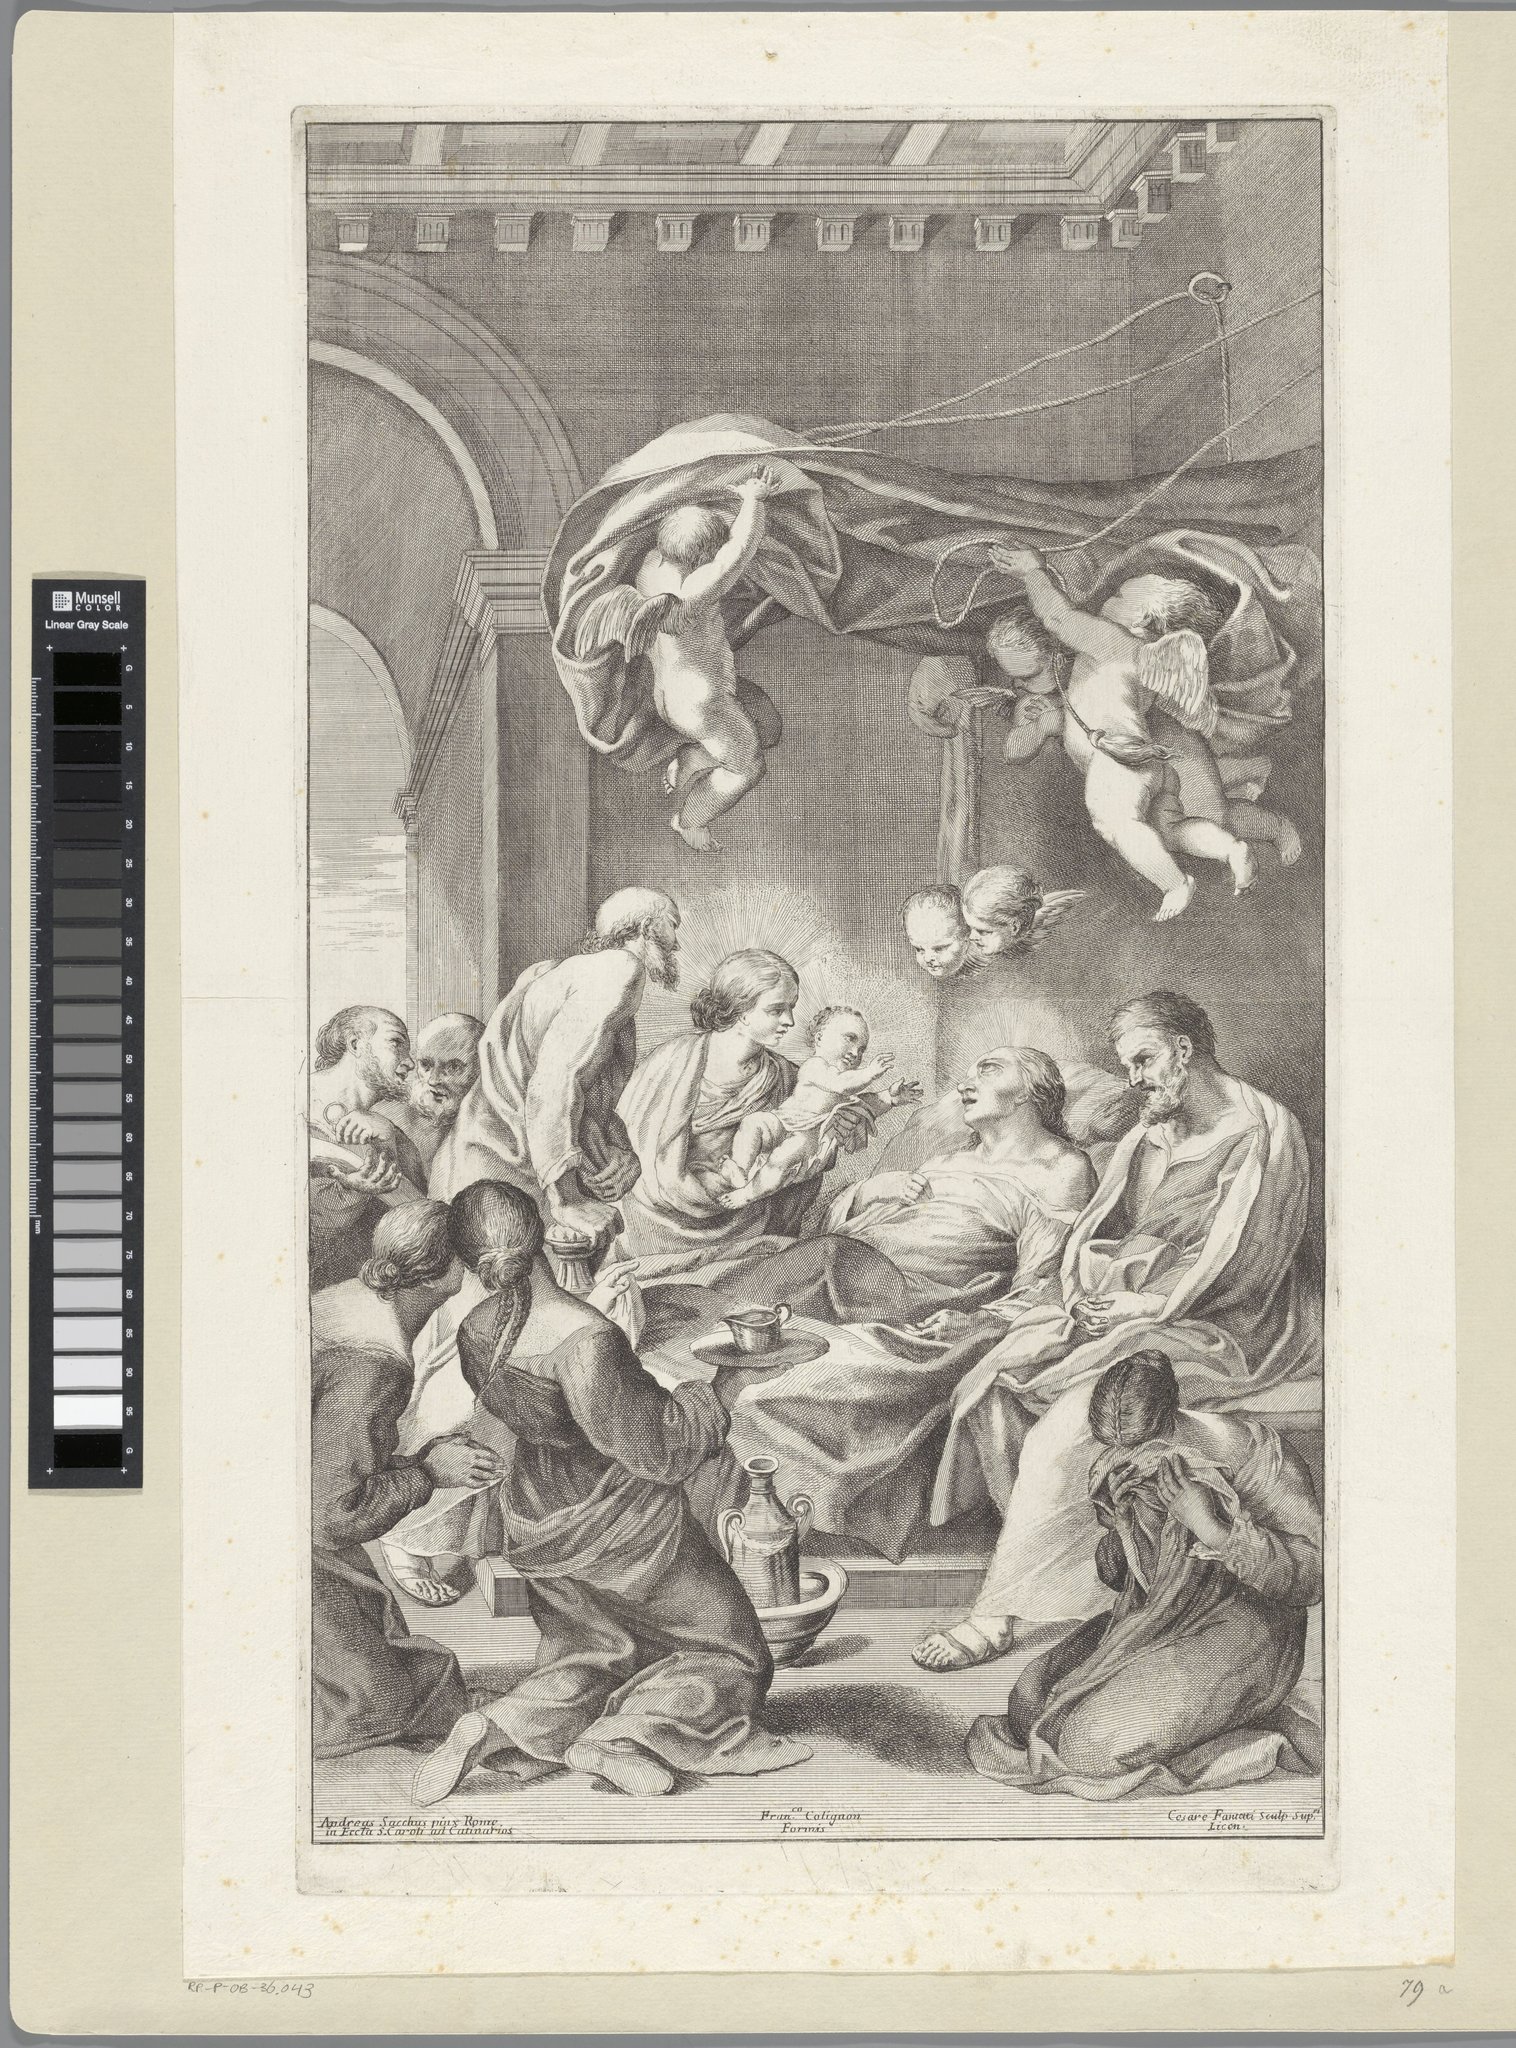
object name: print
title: Dood van H. Anna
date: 1675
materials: paper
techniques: engraving, etching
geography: italy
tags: death of anna, usually mary and christ present, cupids: 'amores', 'amoretti', 'putti'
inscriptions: collector's mark: Lugt 240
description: Maria staat met het Christuskind in haar armen naast het bed van een zieke man. Christus strekt zijn armen uit naar de man. Rond het bed zitten verschillende andere figuren die de zieke man komen bezoeken. Boven het bed zweven cherubijnen en putti.